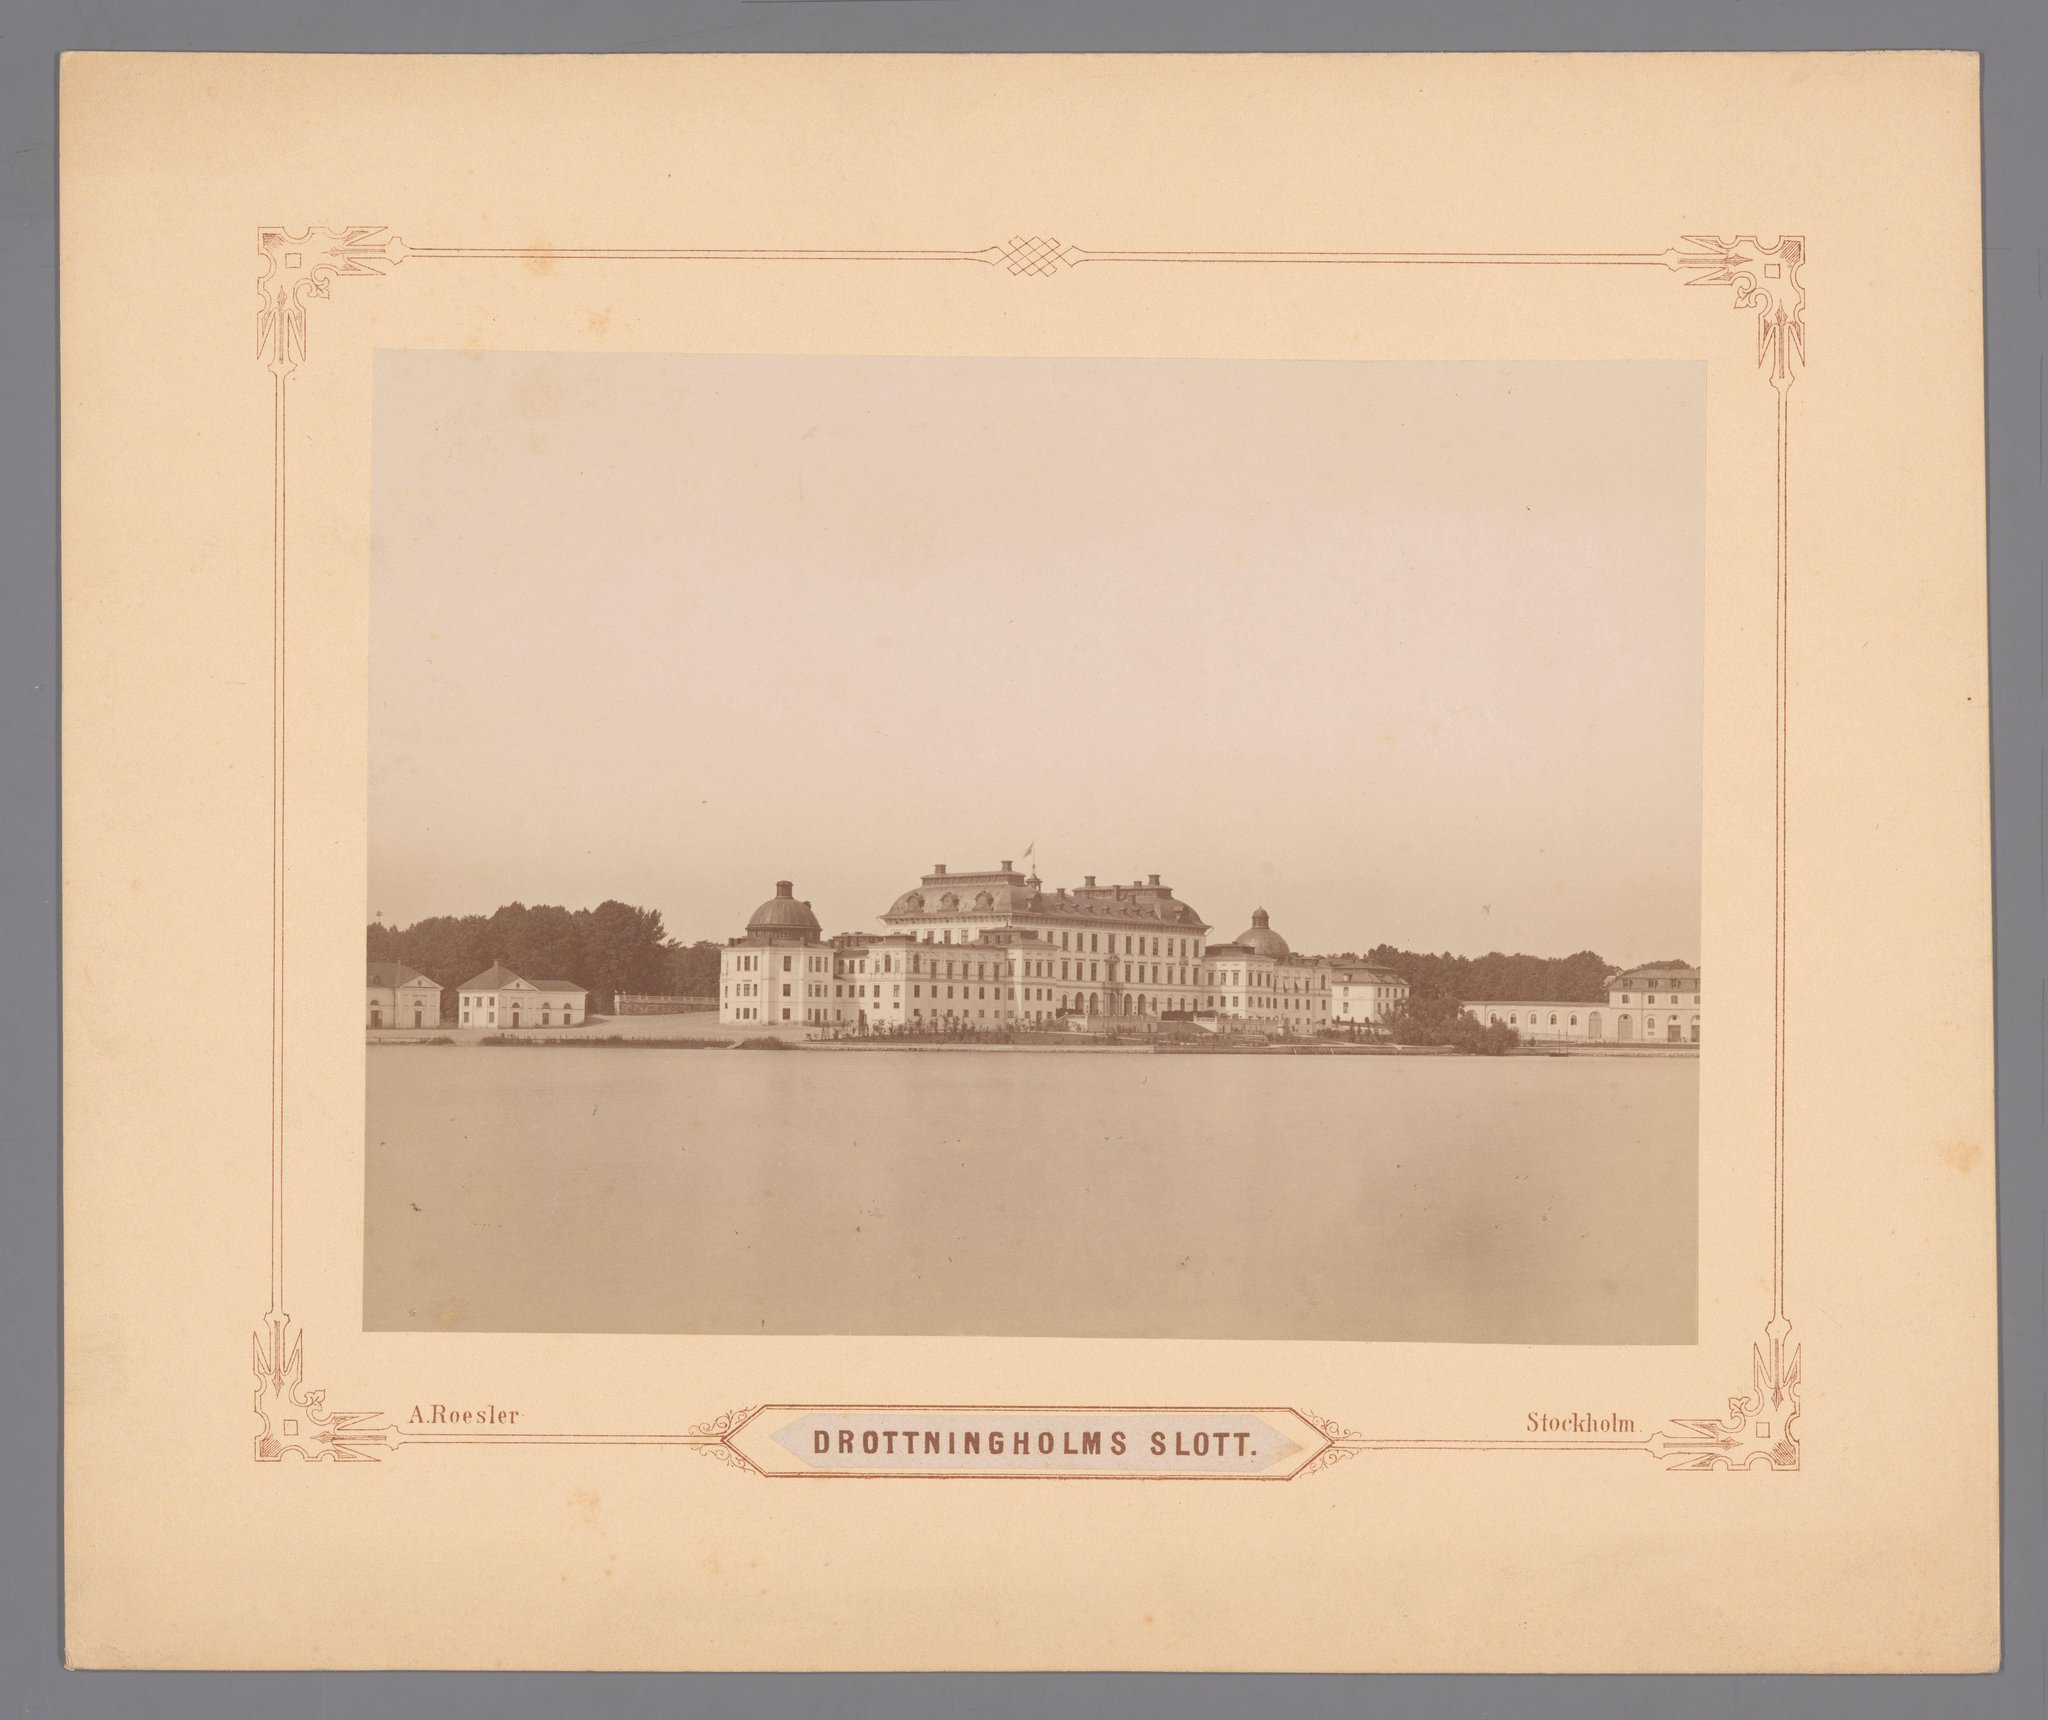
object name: photograph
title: Drottningholms Slott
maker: august roesler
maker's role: fotograaf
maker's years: 1837-1896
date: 1862-1893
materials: cardboard, paper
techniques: albumen print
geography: stockholm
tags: palace